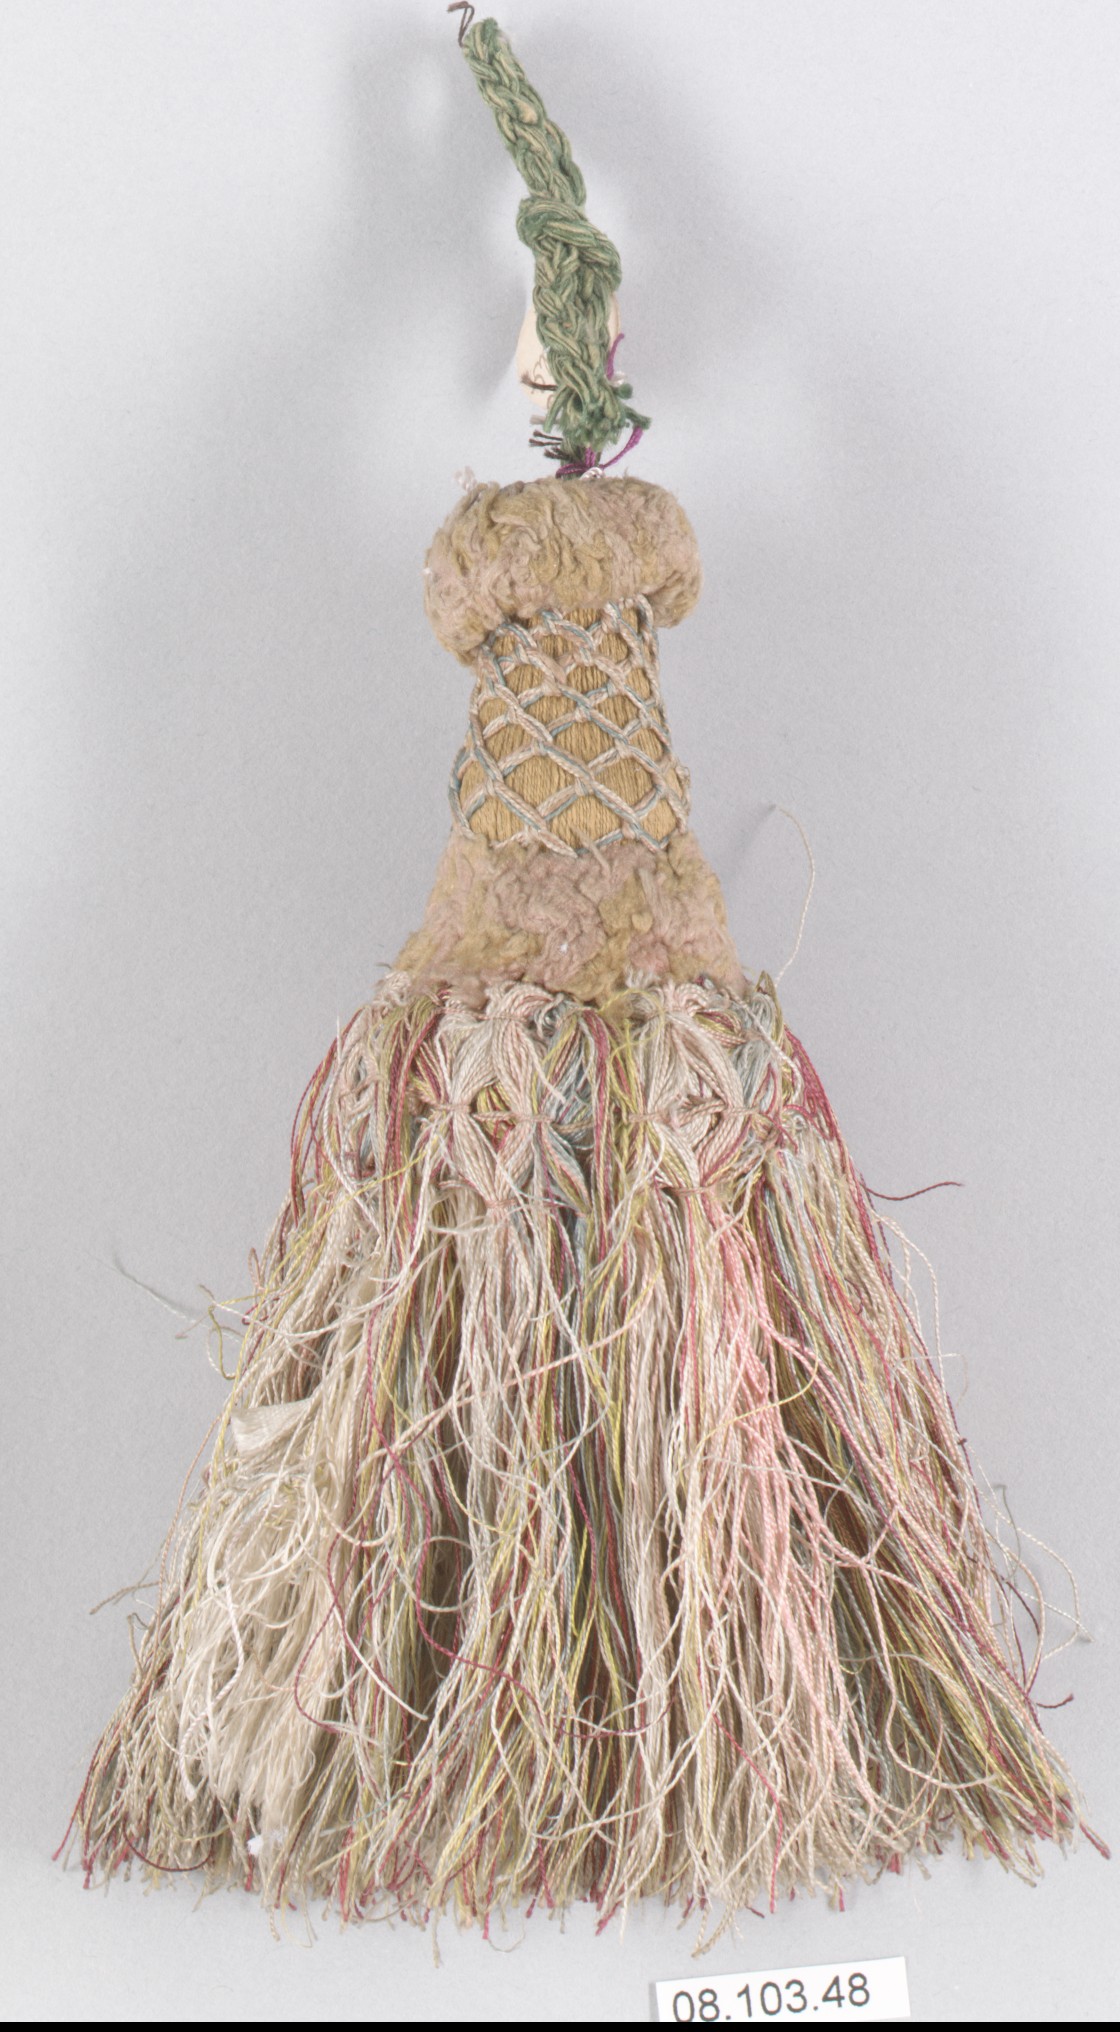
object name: tassel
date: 1701-1800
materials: silk